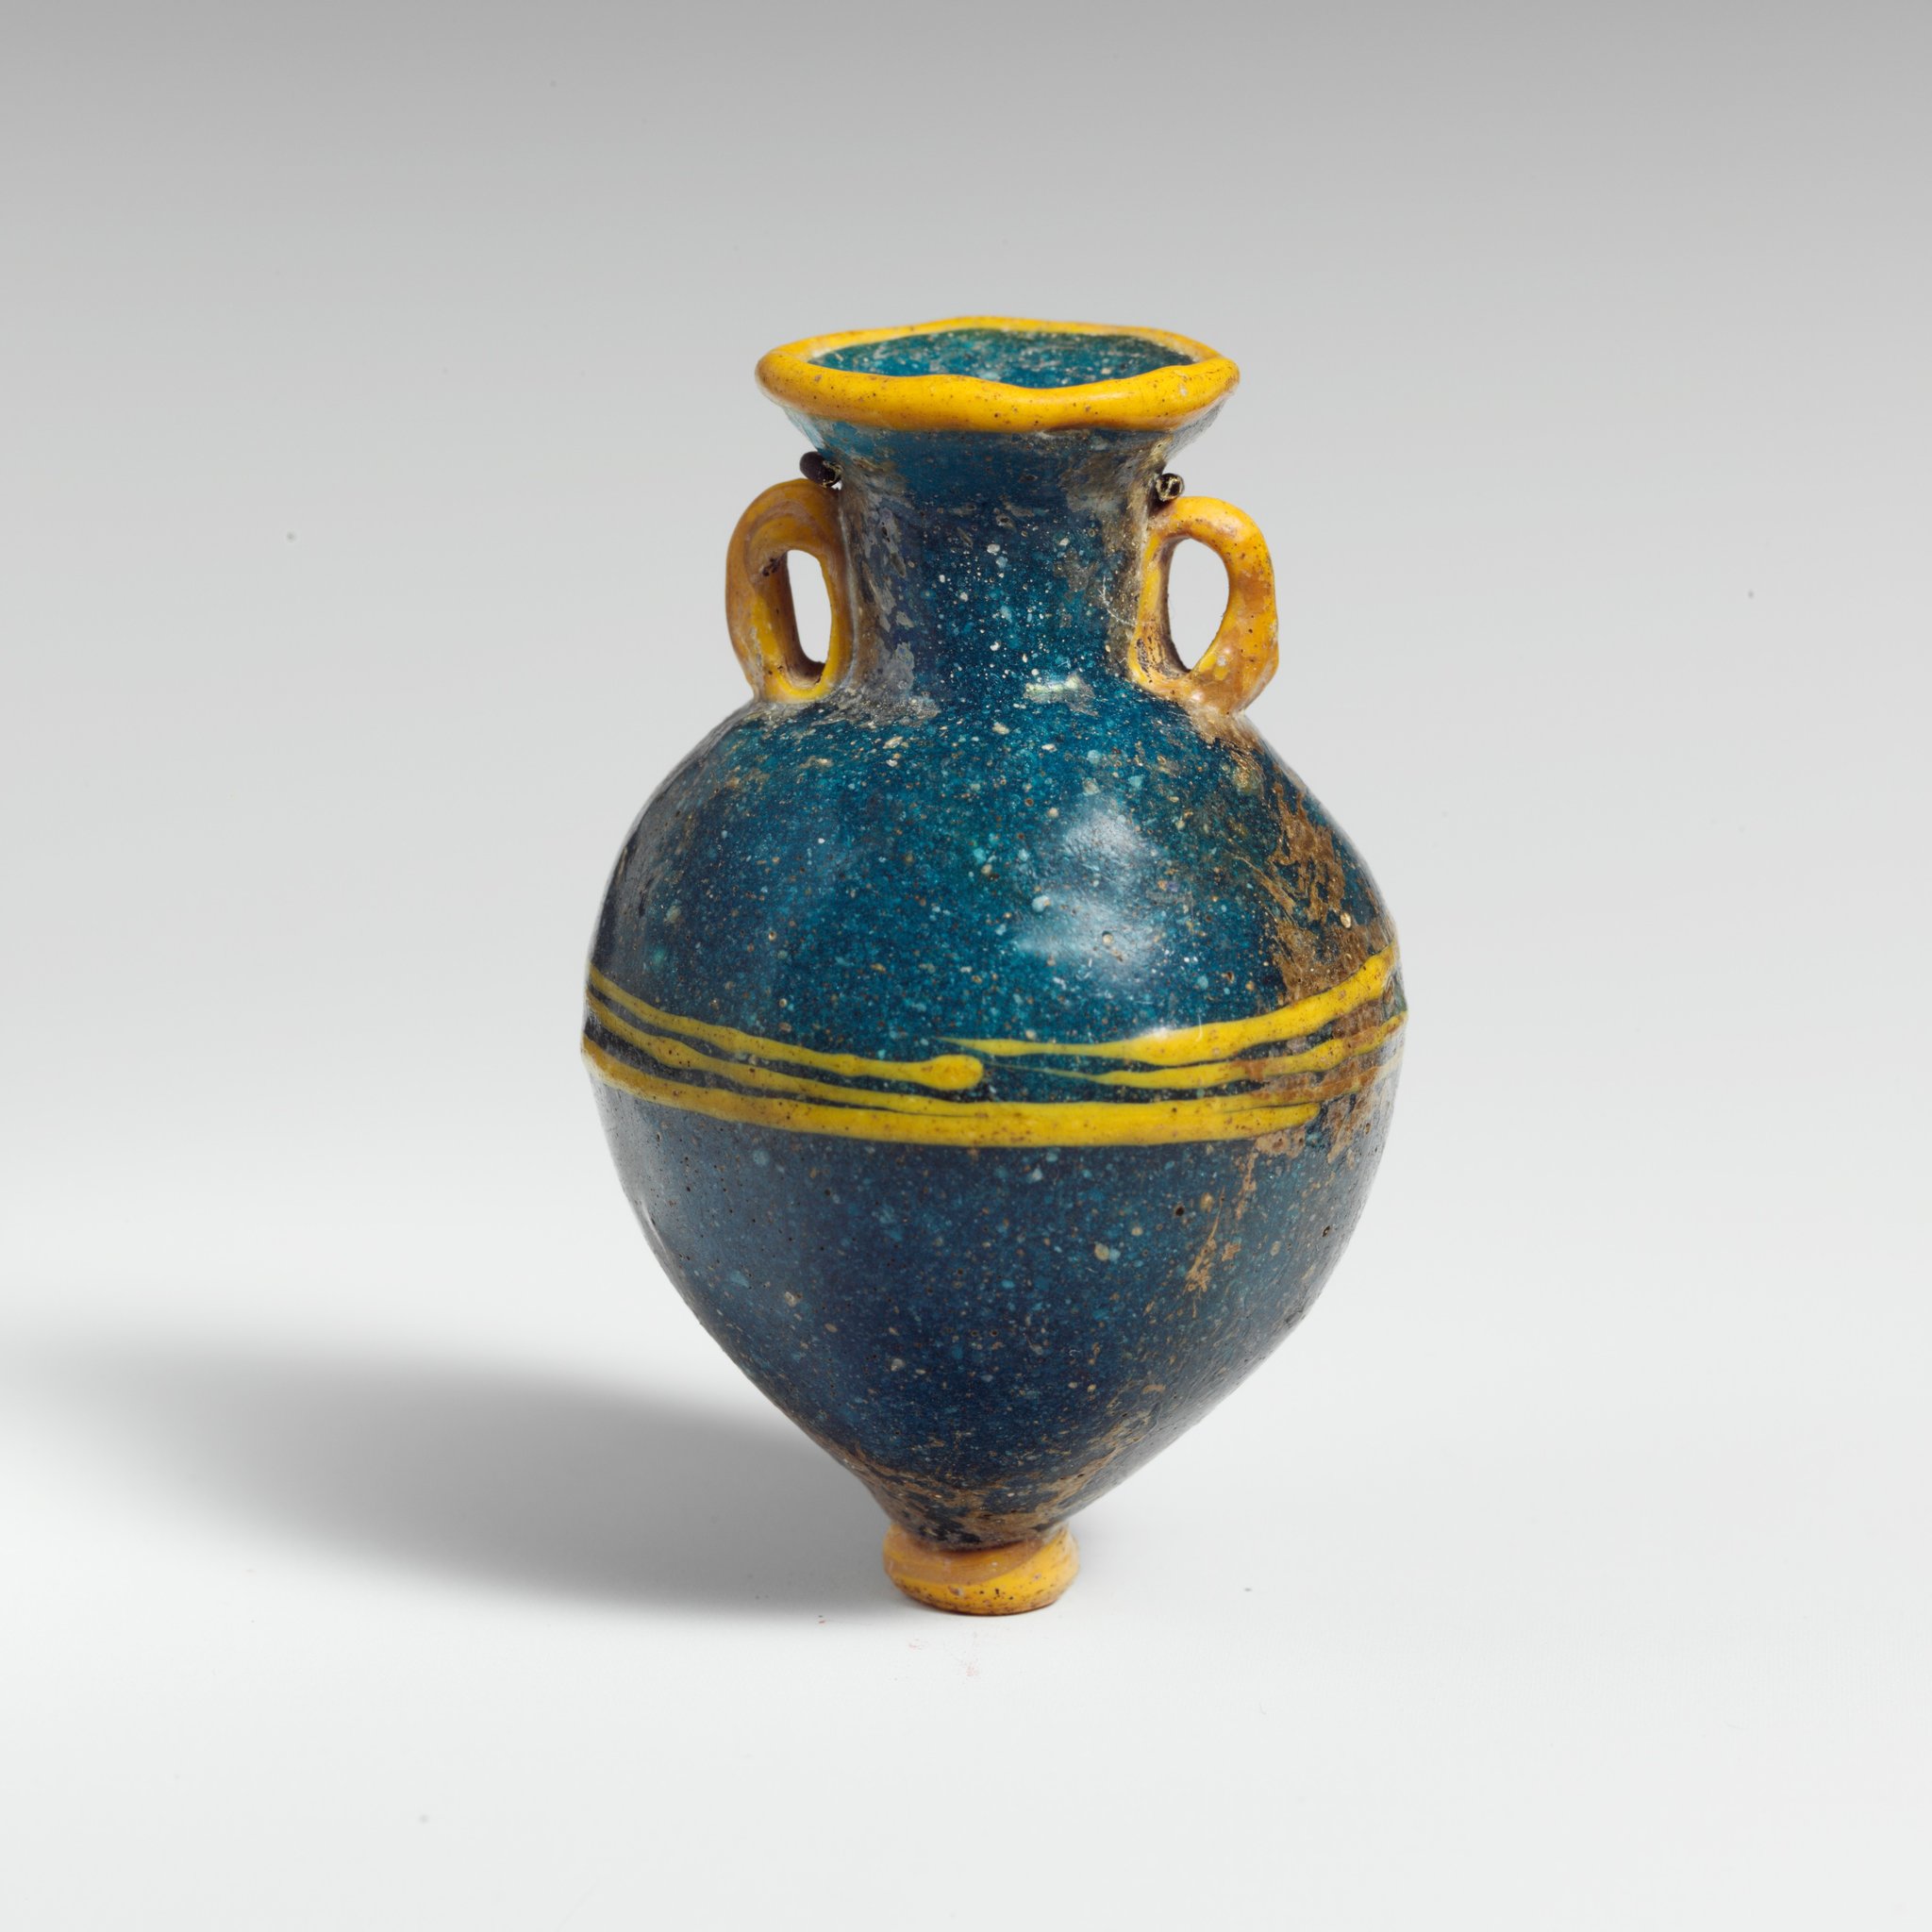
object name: amphoriskos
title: Glass amphoriskos (perfume bottle)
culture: greek, eastern mediterranean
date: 500-401 BCE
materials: glass